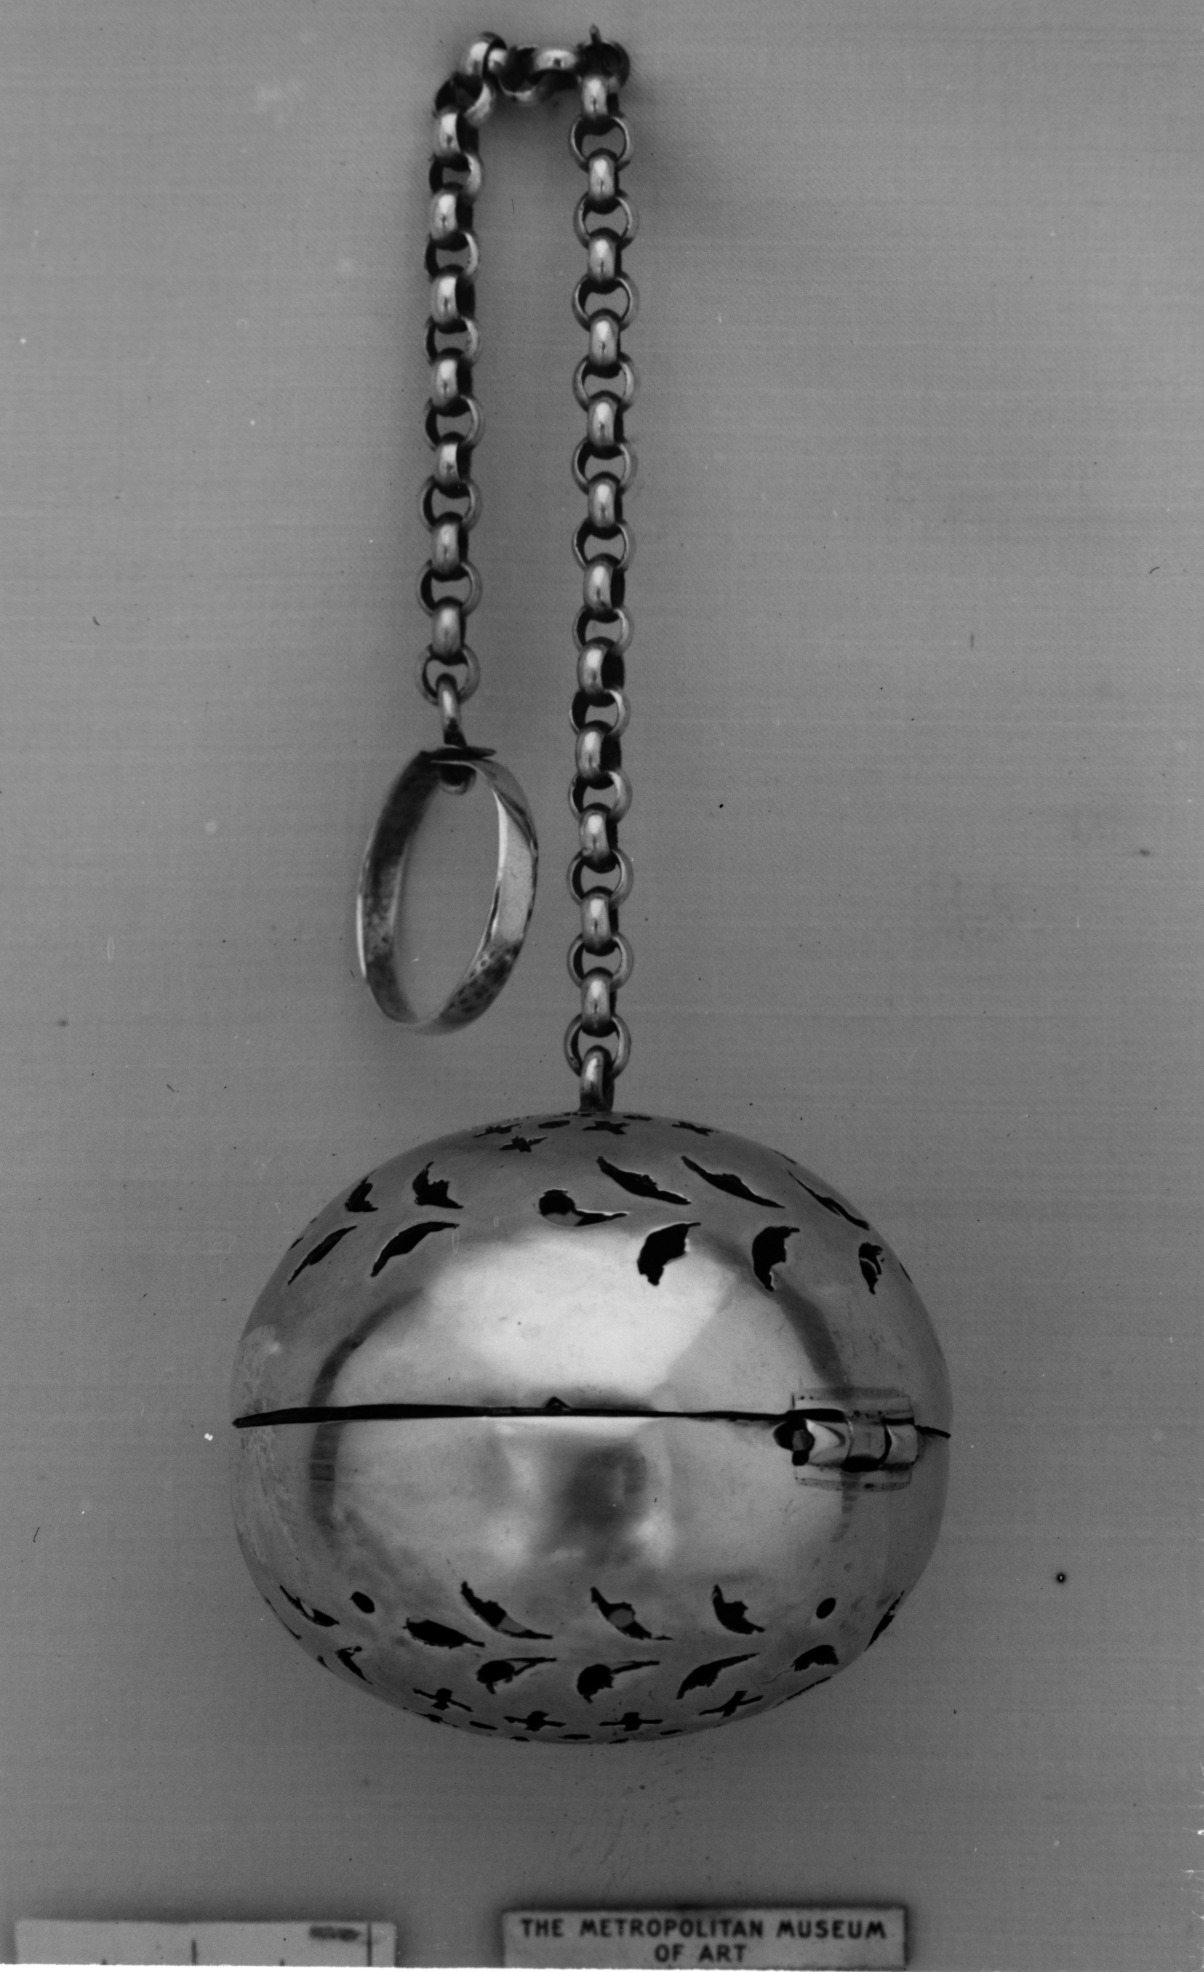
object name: tea ball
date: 1701-1733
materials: silver